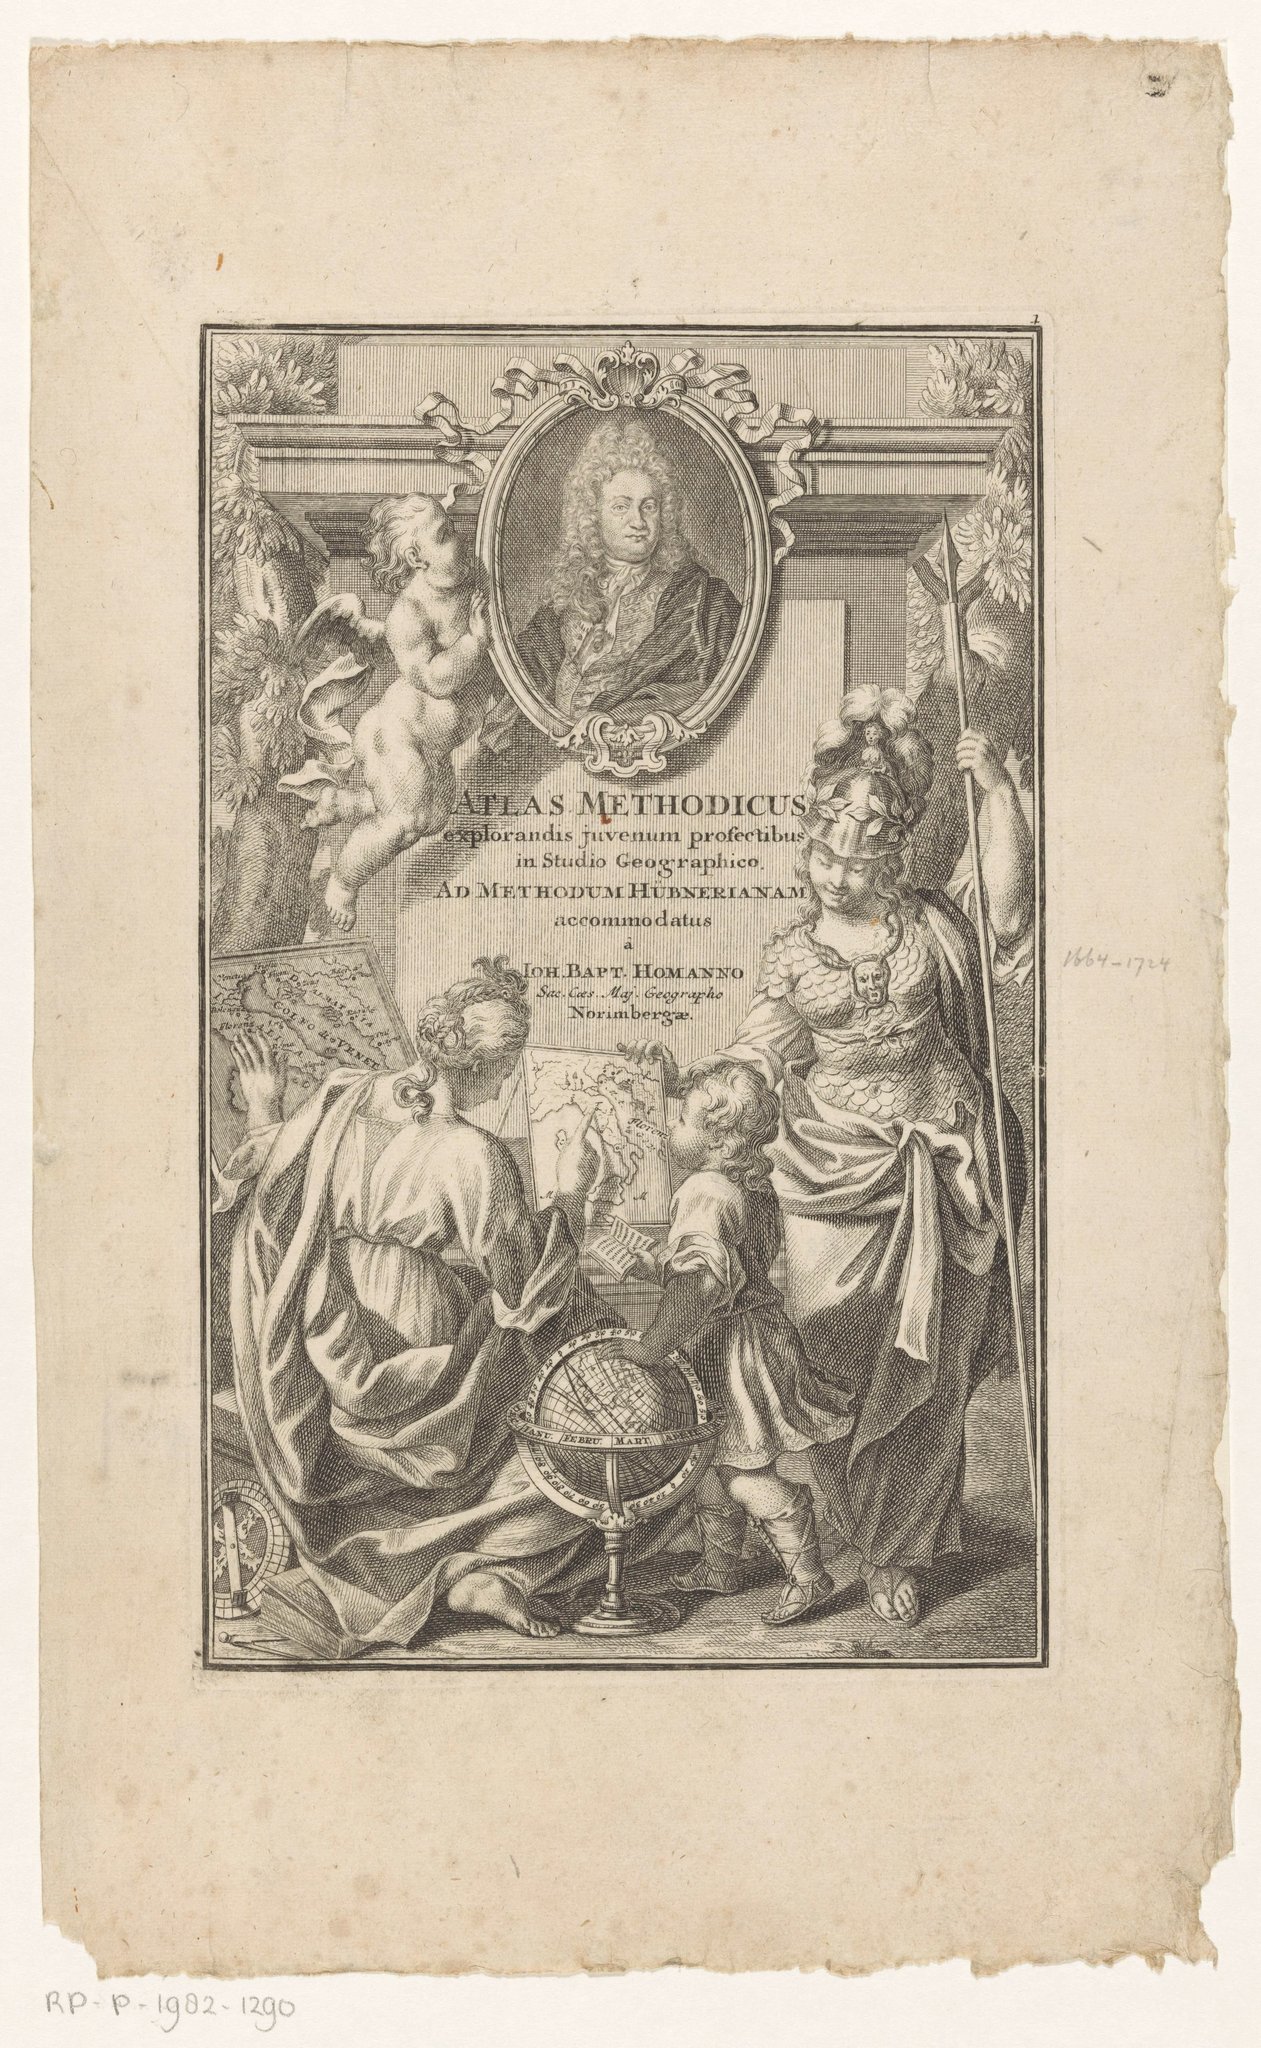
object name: titelblad, titelpagina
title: Minerva en kind bij vrouw met kaarten van Italië en portret van Johann Hübner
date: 1719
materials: paper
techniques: engraving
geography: nuremberg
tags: (story of) minerva (pallas, athena), maps, atlases, child, education, italy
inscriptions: collector's mark: Lugt 2228, collector's mark: Lugt 2760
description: Minerva met helm en lans staat met een kind naast een zittende vrouw op de rug gezien. De zittende vrouw wijst op een kaart van het Italië. Links houdt zij haar hand op een tweede kaart van Italië. Aan de bovenzijde een putto met portret van Johann Hübner.